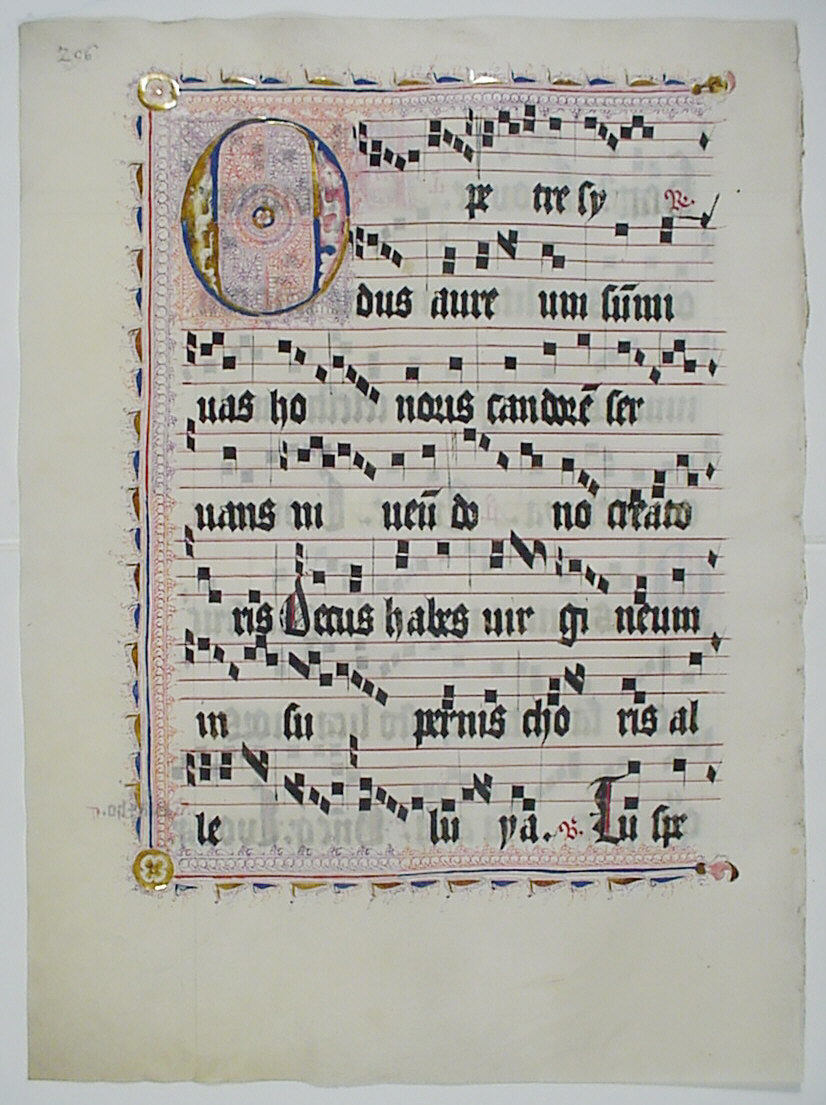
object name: antiphonary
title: Manuscript Leaf with Initial O, from an Antiphonary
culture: german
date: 1426-1450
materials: ink, metal leaf, parchment, paint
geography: germany